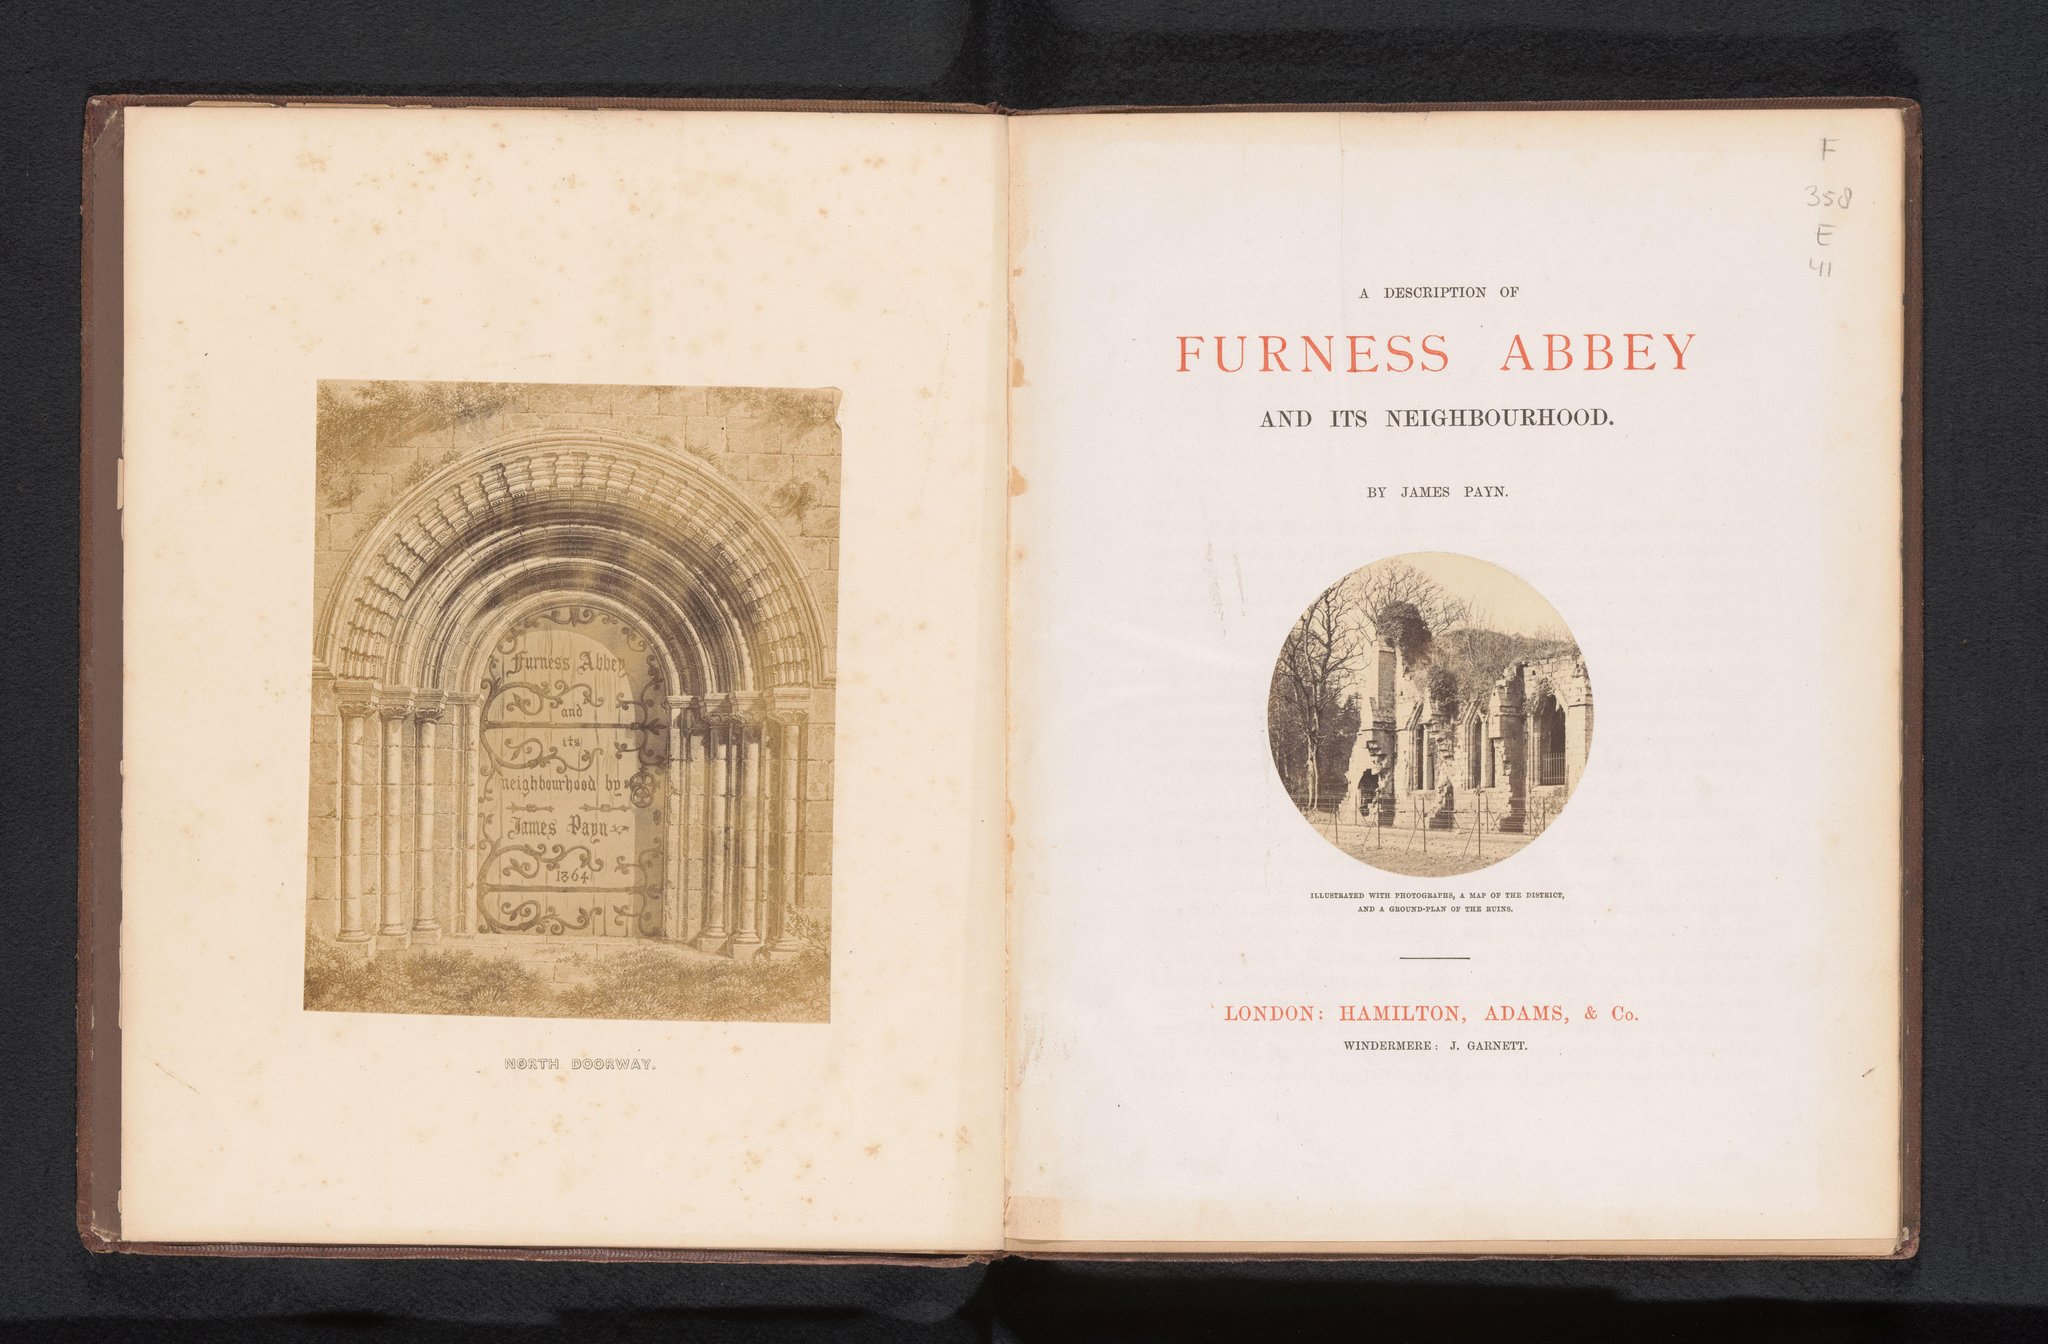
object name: photograph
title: North doorway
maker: Anonymous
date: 1859-1864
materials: photographic support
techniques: albumen print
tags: parts of church exterior and annexes: portal